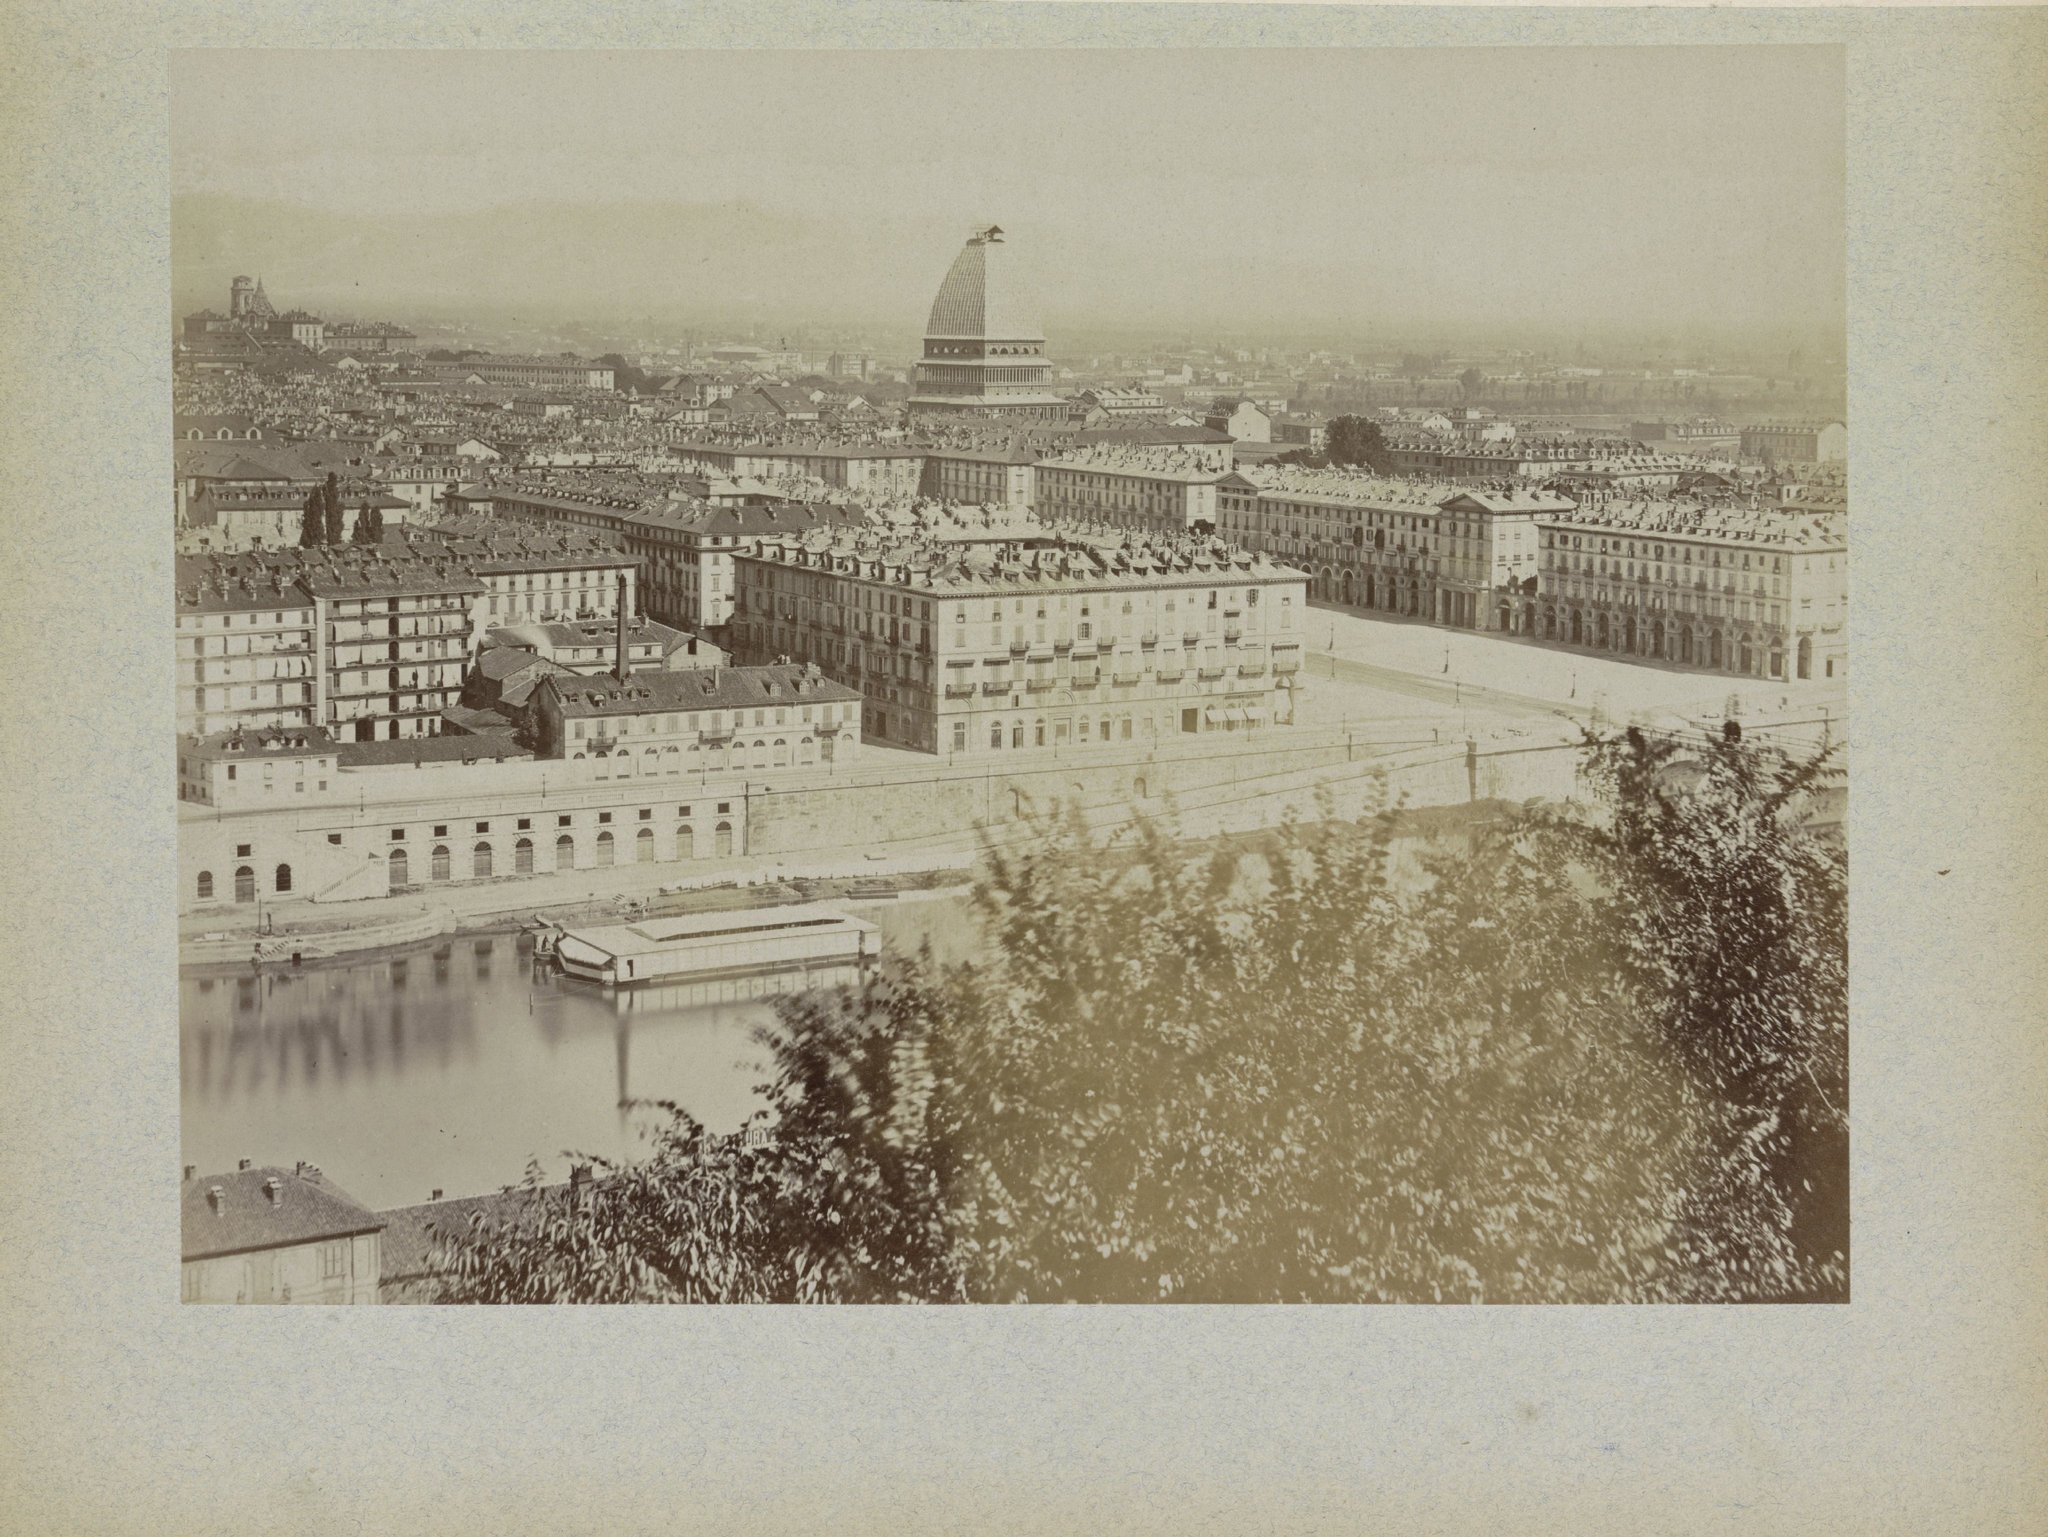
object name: photograph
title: Gezicht op Turijn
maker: Anonymous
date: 1885-1900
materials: paper, photographic support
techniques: albumen print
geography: turin